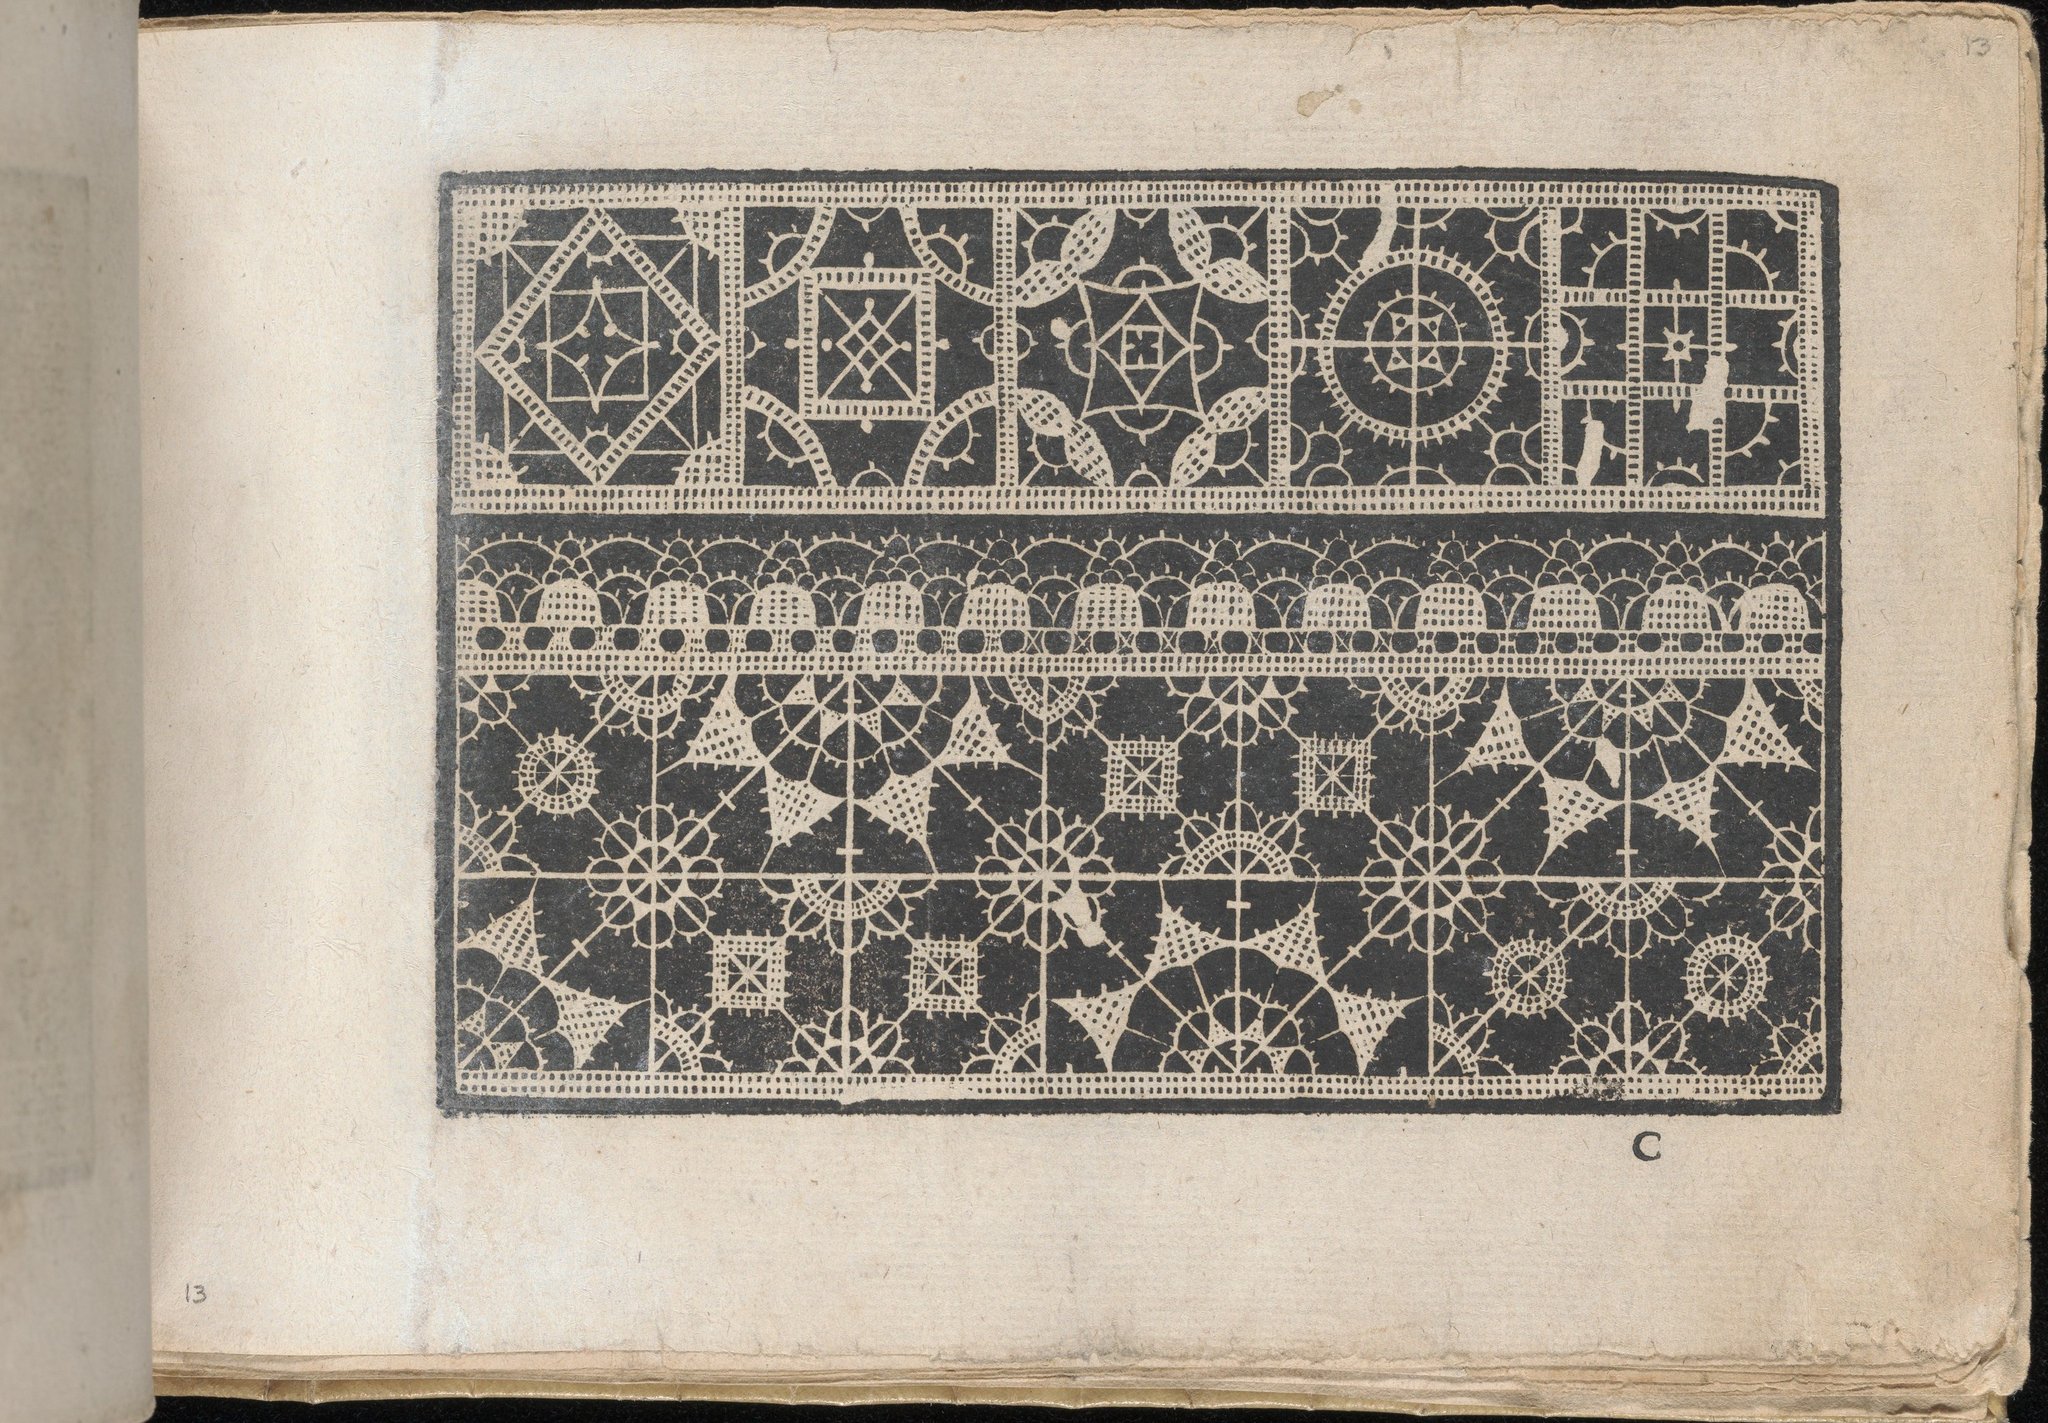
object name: book print ornament archiecture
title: Fiori di Ricami Nuovamente Posti in Luce, page 13 (recto)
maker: matteo florimi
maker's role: designer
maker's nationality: italian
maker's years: 1581-1613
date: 1591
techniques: woodcut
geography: italy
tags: ornament